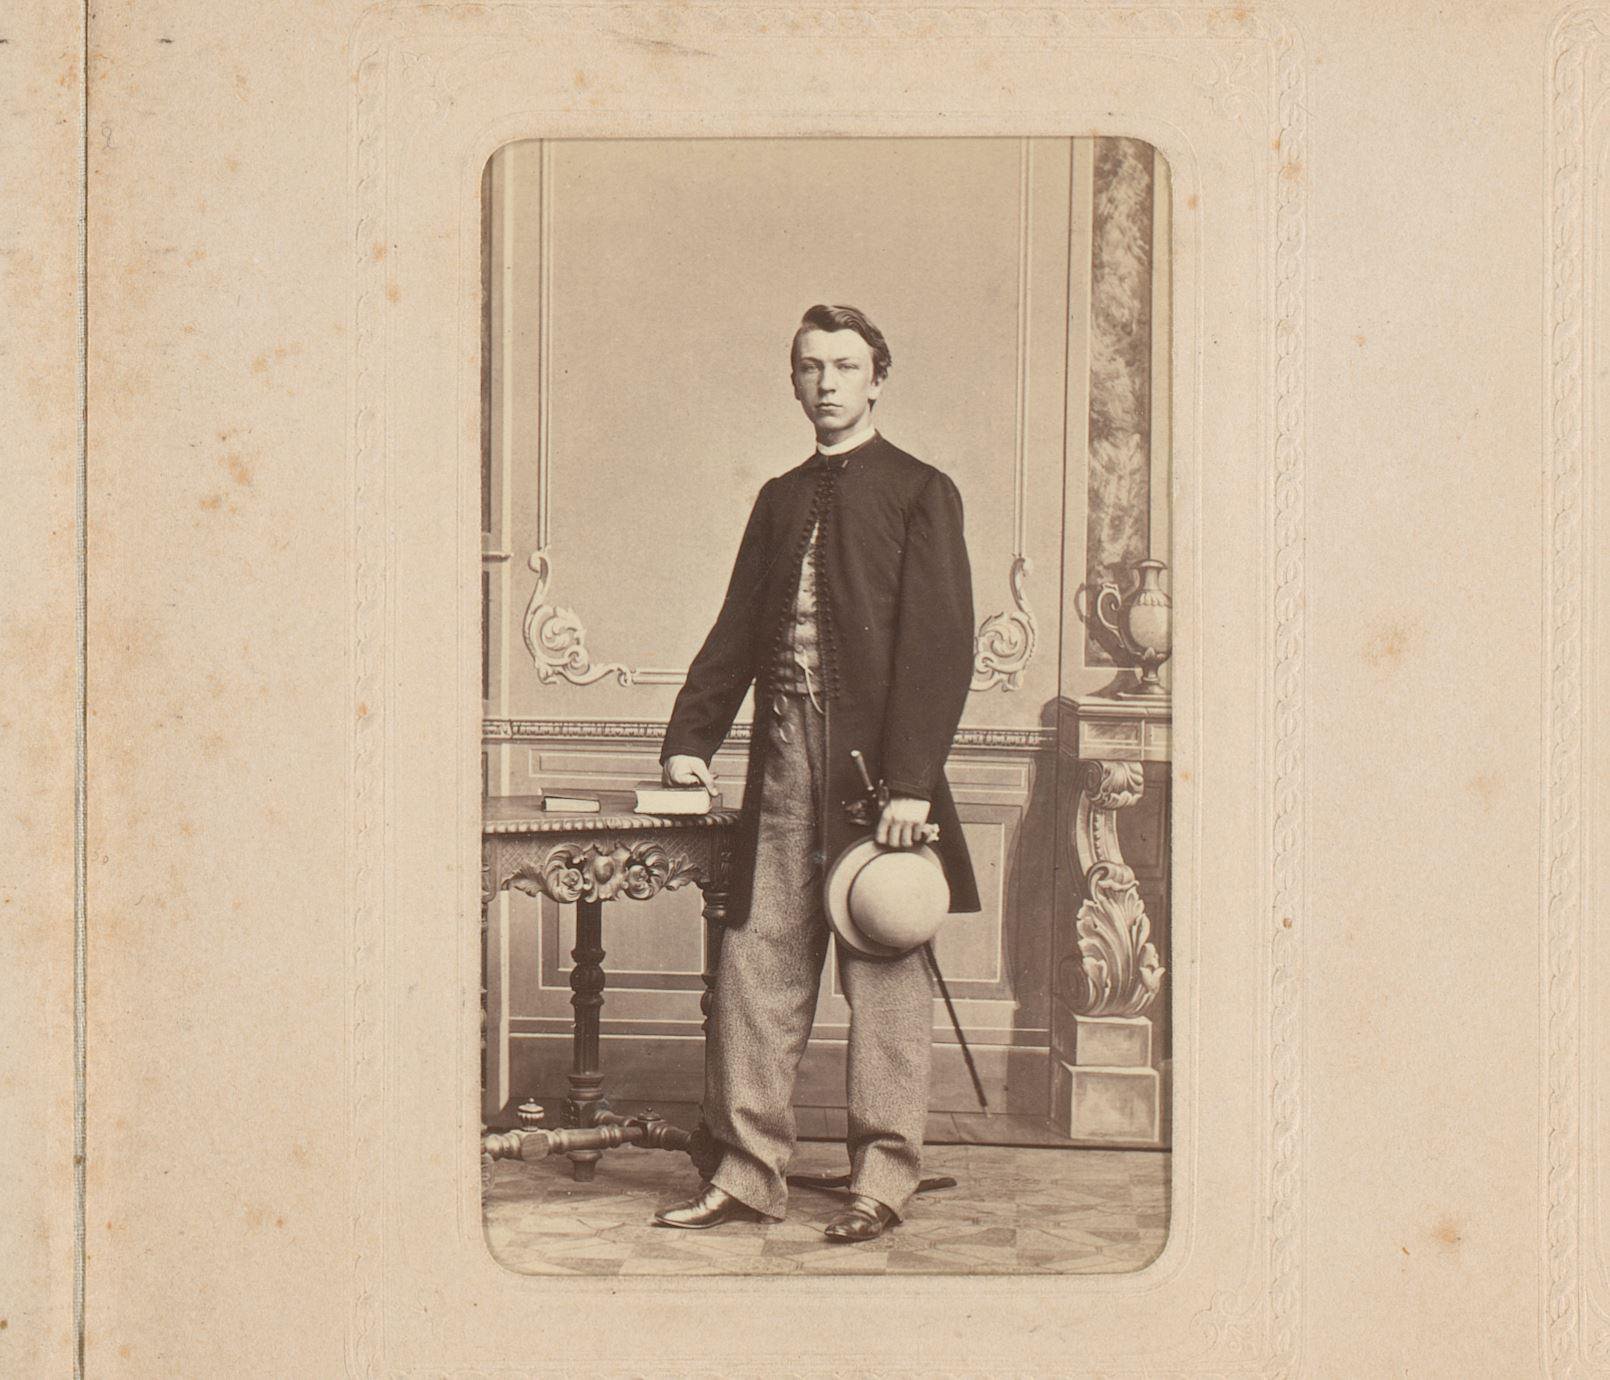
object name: photograph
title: Portret van een jonge man met hoed en wandelstok in de hand, staand bij een tafel met twee boeken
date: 1860-1900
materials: cardboard, photographic support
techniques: albumen print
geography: prague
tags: head-gear: bowler hat, walking-stick, staff, historical persons, youth, adolescent, book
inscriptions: inscription: ‘Photografie/ von/ LANGER & POMMERRENIG/ No C 372 1/ Obstgasse.’